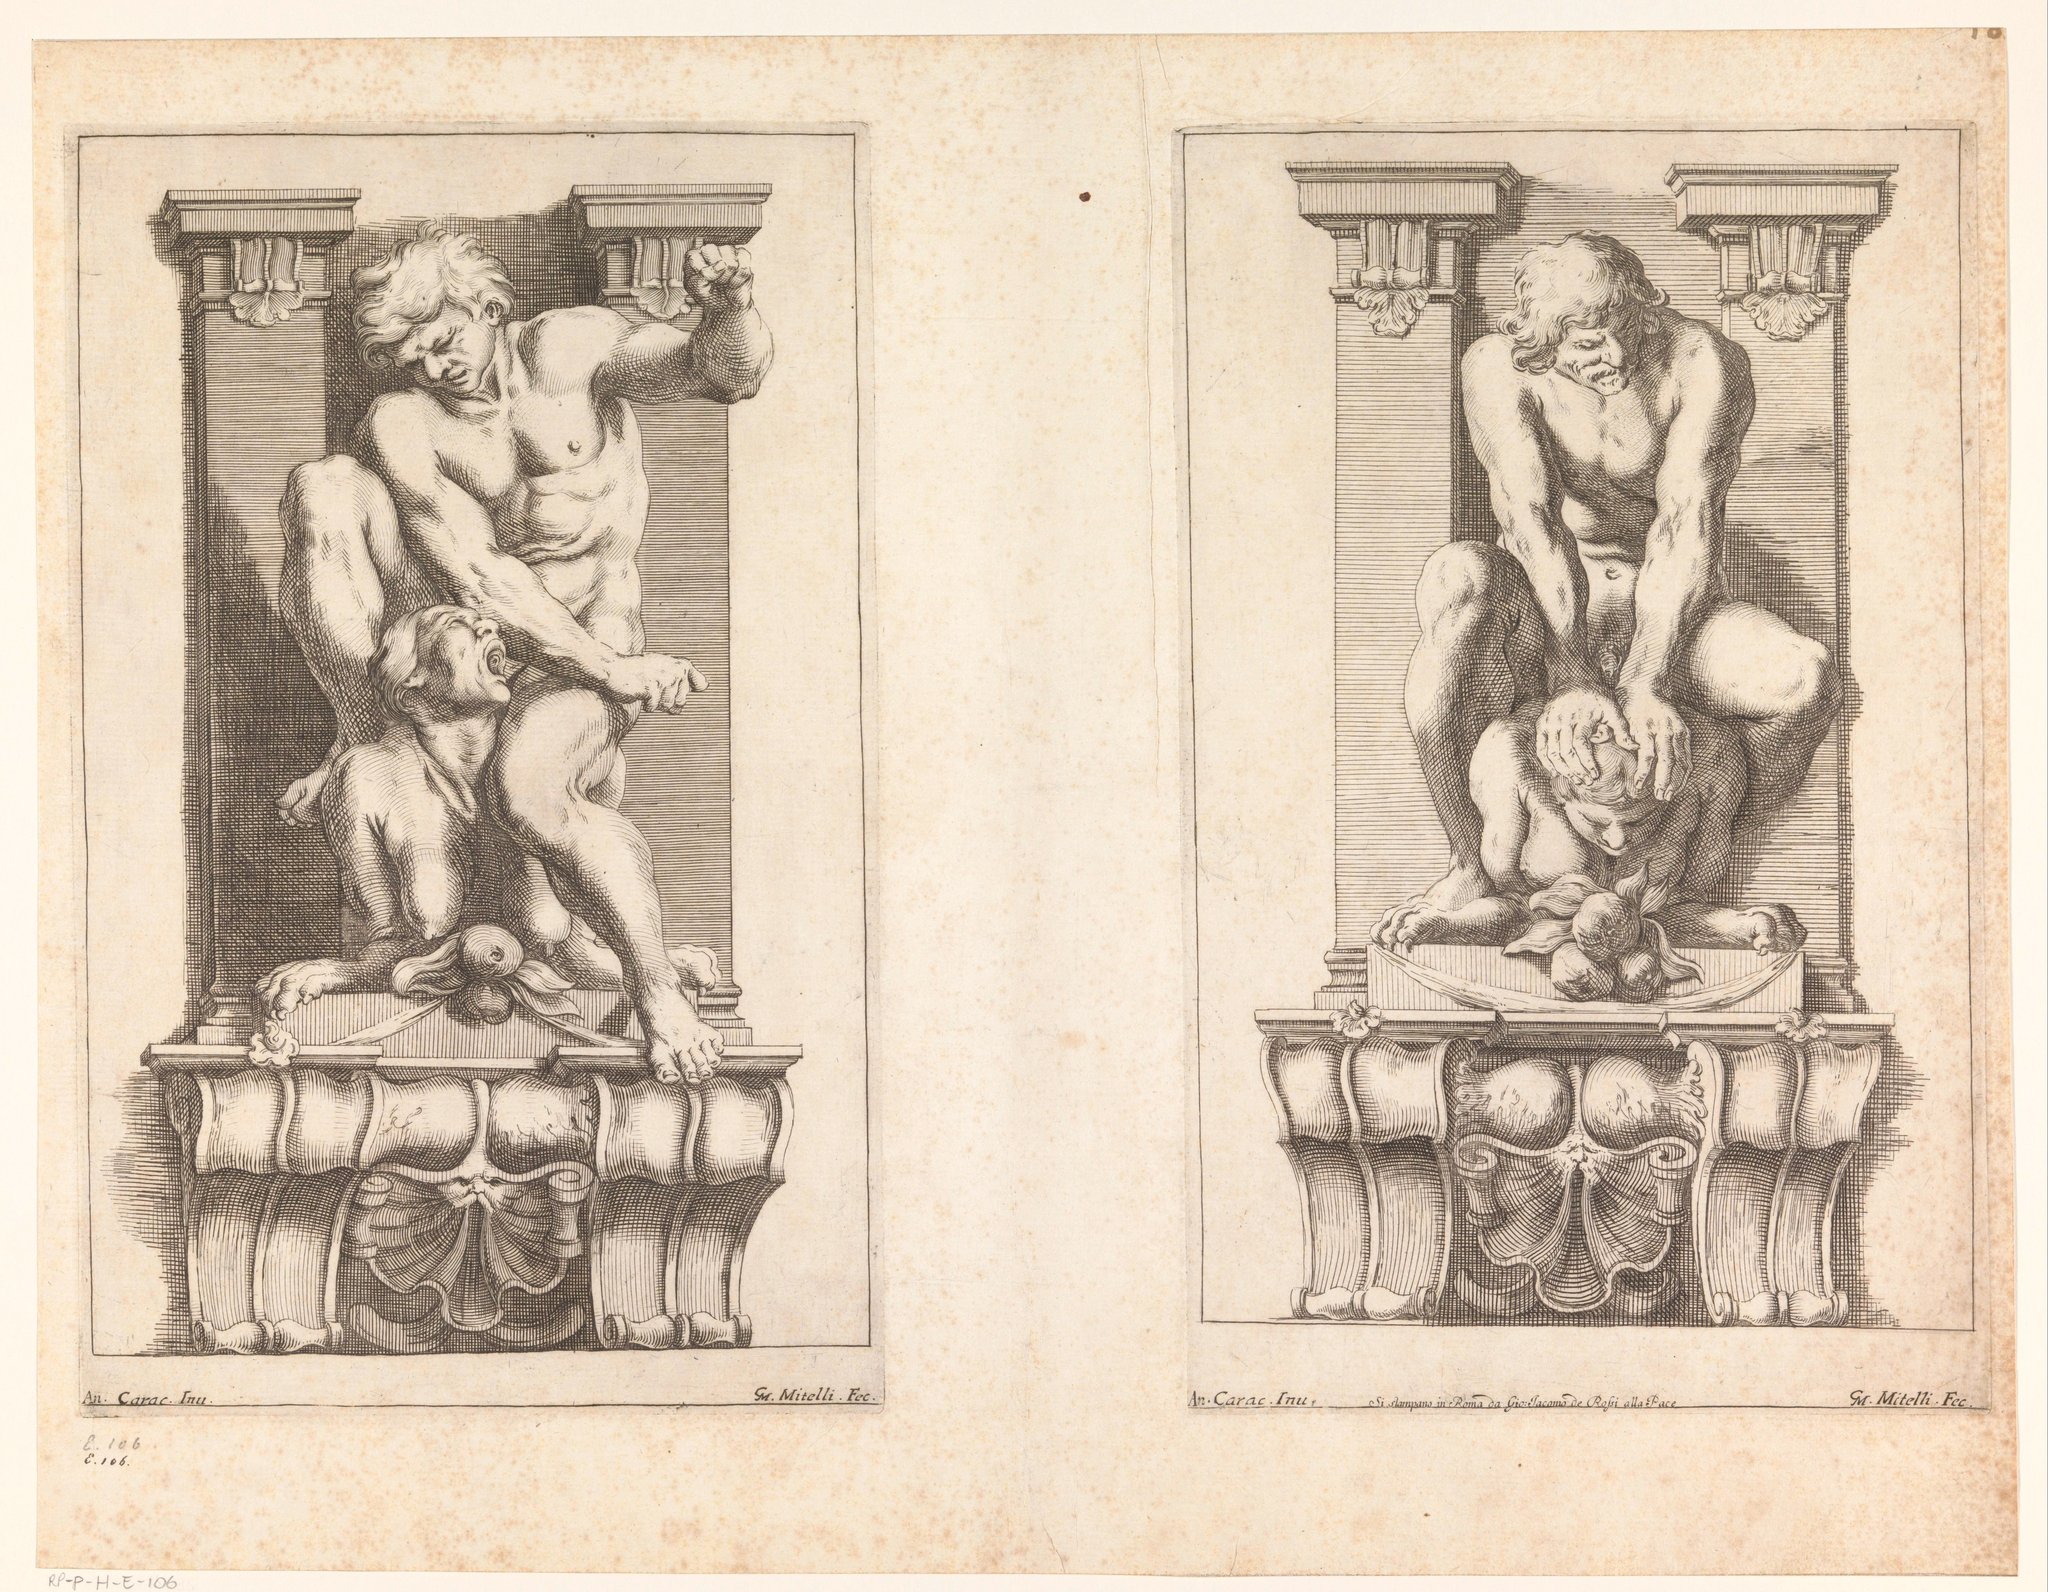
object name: print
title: Omzwervingen van Aeneas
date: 1663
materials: paper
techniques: etching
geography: italy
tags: the (nude) human figure; 'corpo humano' (ripa), other architectural details (console), harpies (classical mythology)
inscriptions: collector's mark: ‘Hinloopen’, collector's mark: Lugt 11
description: Deze prent maakt deel uit van een reeks van 20 prenten (+ titelprent) naar de fresco's door de Carracci's in Palazzo Fava Ghisilieri te Bologna. Deze prent maakte oorspronkelijk deel uit van liber nr. 22 van de Atlas van Rome, uit de collectie Hinloopen. In dit album waren een aantal prentreeksen naar bekende zeventiende eeuwse frescoseries bijeengebonden. In 1709 heeft Schijnvoet op last van de burgemeesters van Amsterdam de collectie herordend. De prenten uit liber 22 kwamen terrecht in Schijnvoet boek nr. 10. De laatst gedateerde reeks in het album is gedateerd 1691. Het album moet dus na deze datum gebonden zijn. De band is in de Rijksakademietijd uit elkaar gehaald. De marges van de prenten zijn bij het opbergen in het Rijksprentenkabinet vaak drastisch afgesneden. Van een aantal series waren de prenten teruggeslagen om in het album te passen. (Zie: Waals, Jan van der. De prentschat van Michiel Hinloopen. 's-Gravenhage: SDU uitgeverij, 1988, pp. 173-174.)